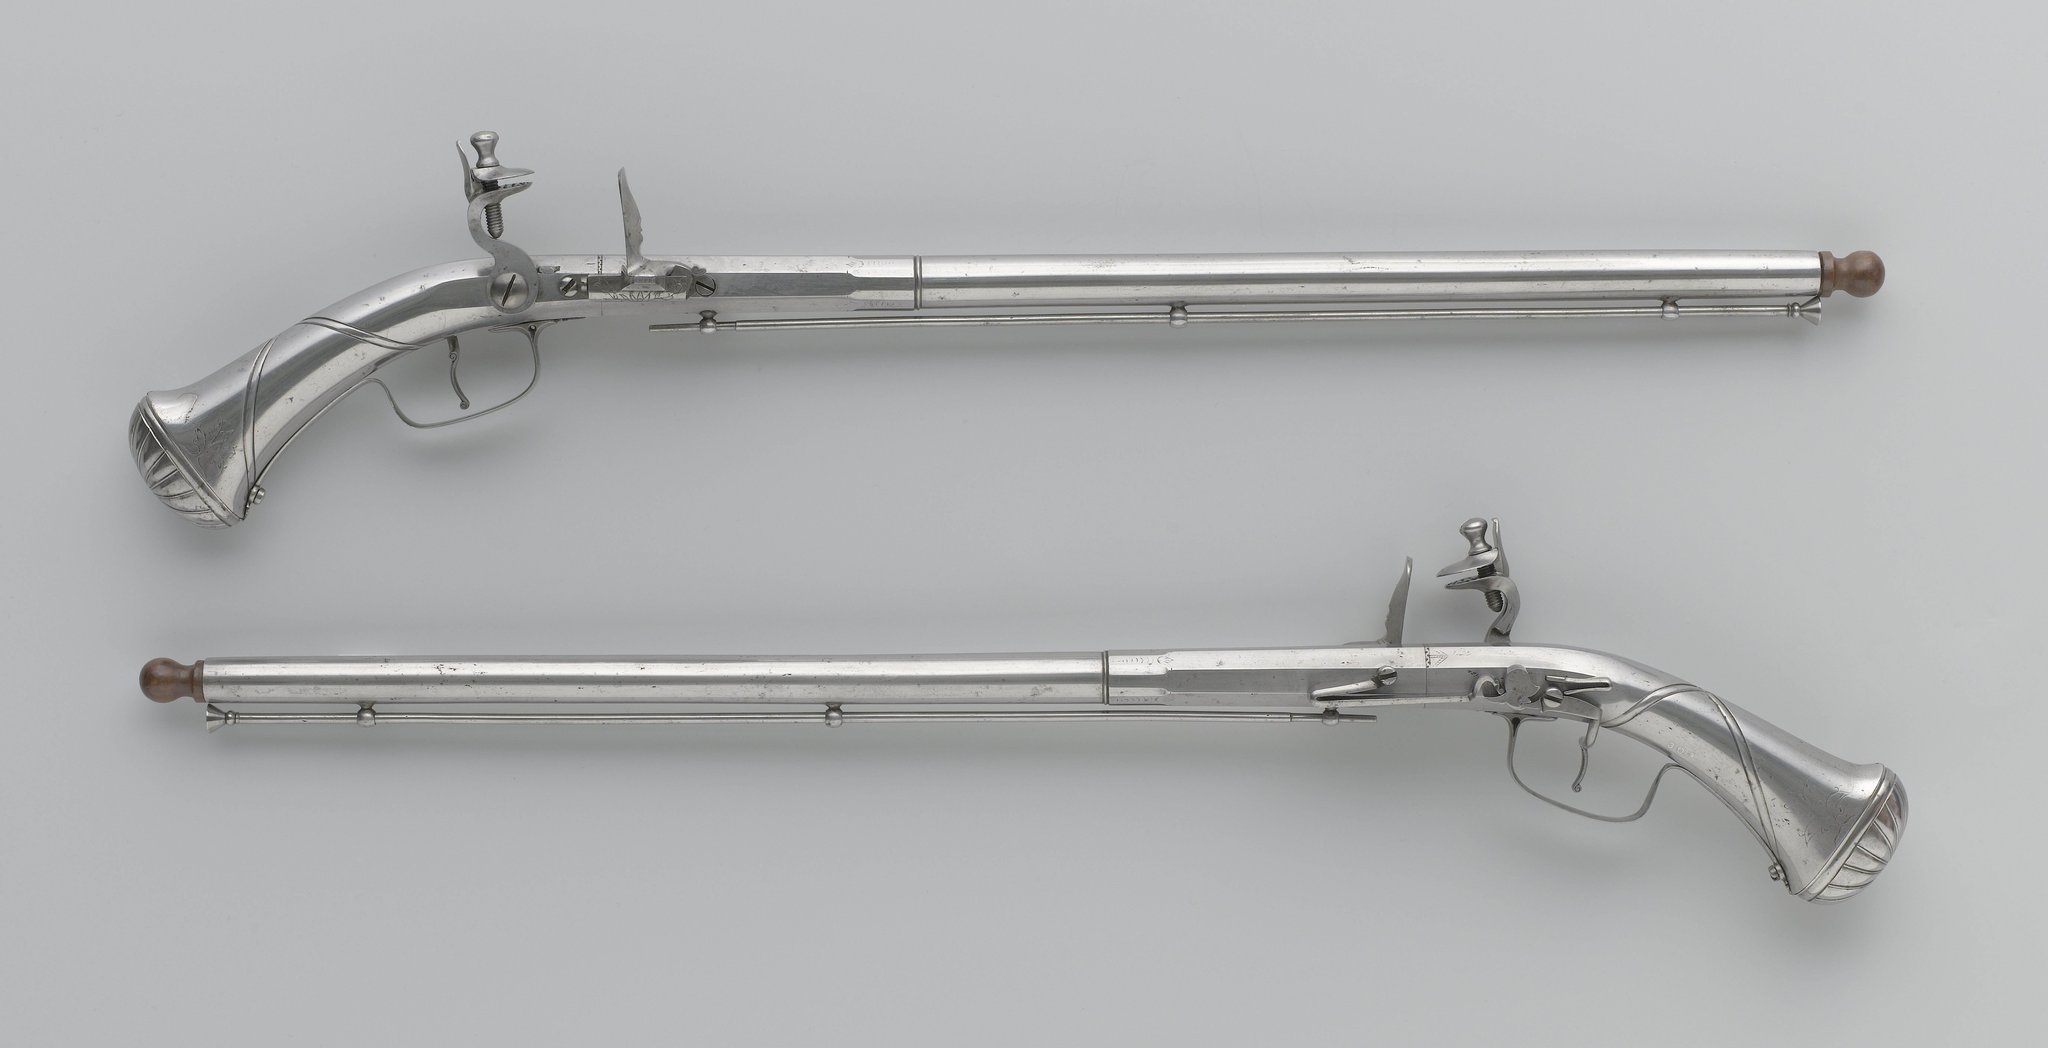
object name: flintlock pistol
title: Vuursteenpistool met ijzeren kolf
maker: Anonymous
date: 1645-1650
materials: iron, steel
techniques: engraving, soldering